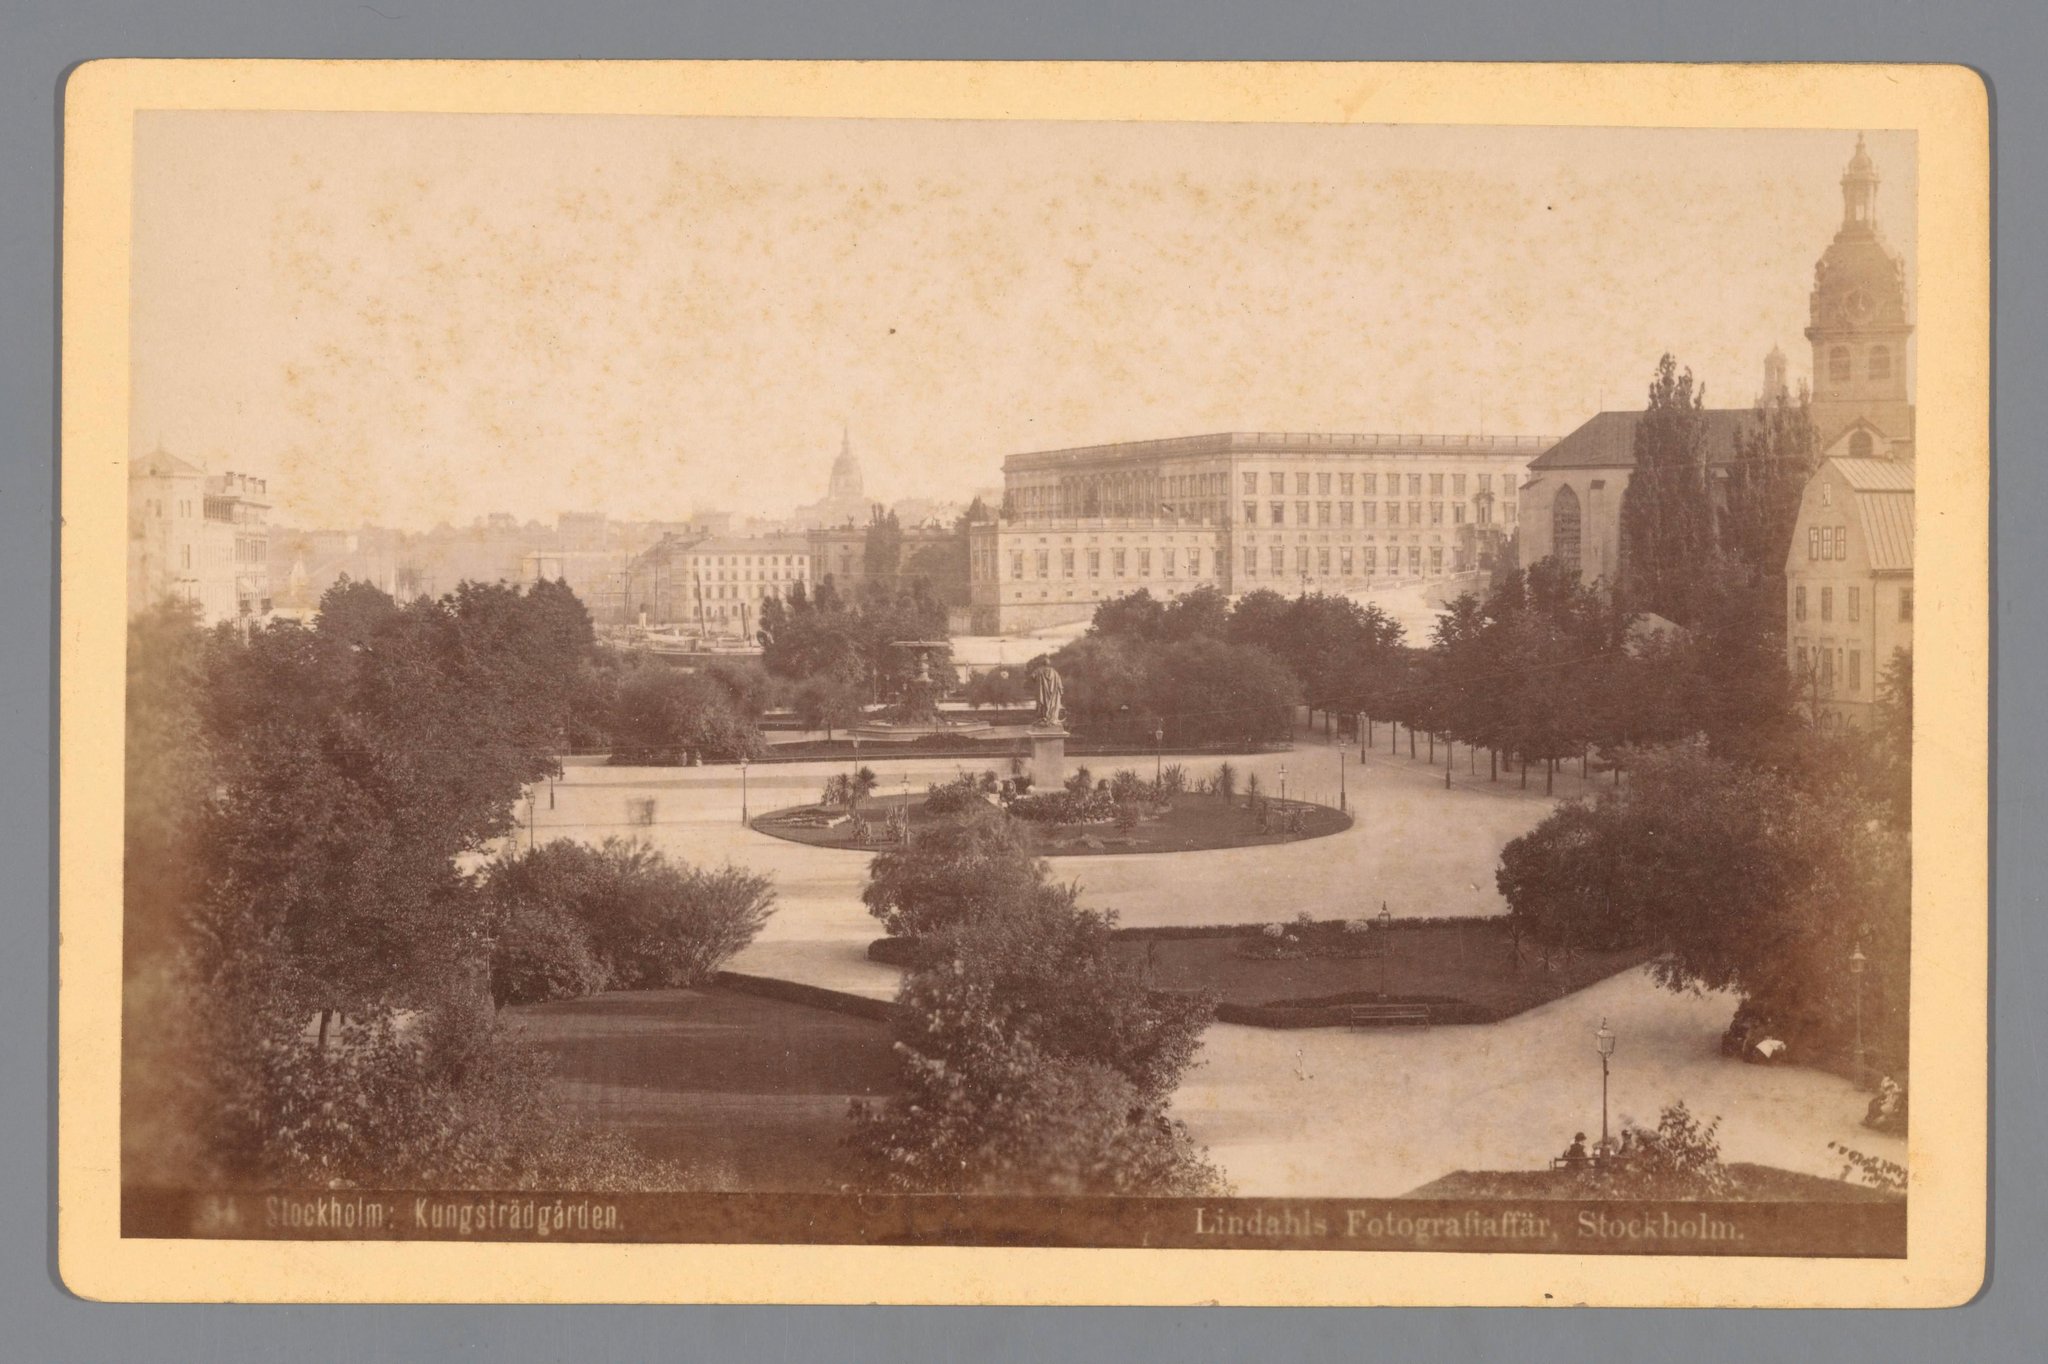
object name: photograph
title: Gezicht op de Kungsträdgården in Stockholm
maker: axel lindahl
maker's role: fotograaf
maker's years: 1841-1906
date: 1890-1895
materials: cardboard, photographic support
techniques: albumen print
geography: stockholm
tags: public gardens, park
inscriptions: number: ‘34.’